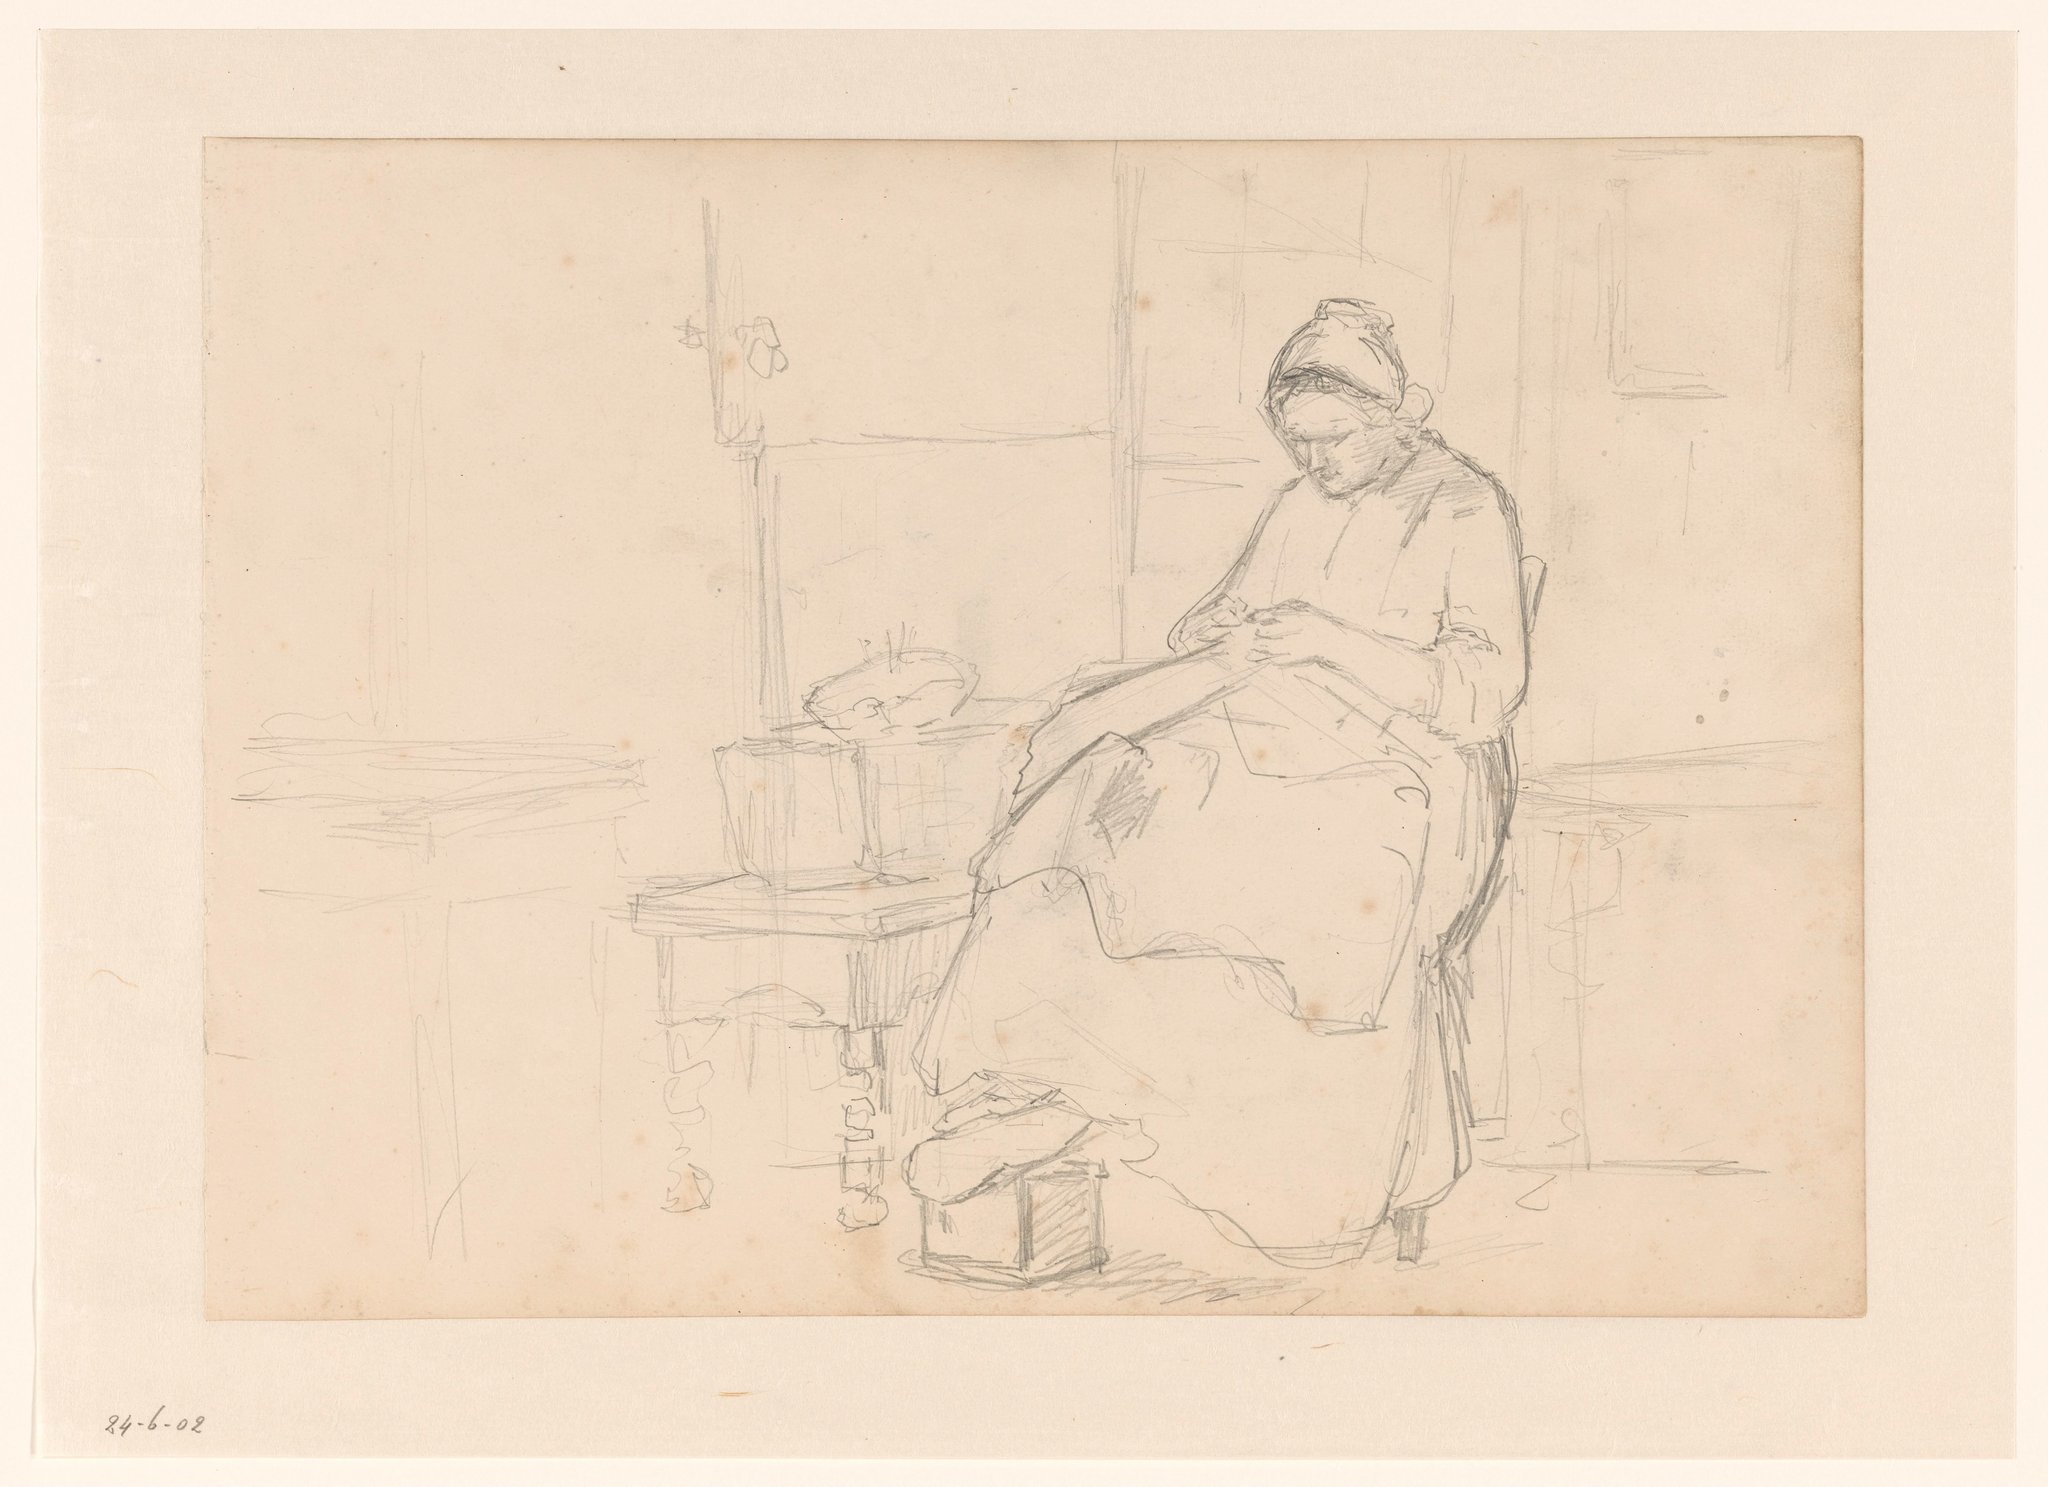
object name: watercolor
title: Zittende vrouw met naaiwerk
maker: hendrik valkenburg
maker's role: draughtsman, painter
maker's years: 1826-1896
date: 1836-1896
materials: paper, pencil, watercolor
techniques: brush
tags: interior of the house, home sewing; repair of clothes, household management; housewife at work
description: Zittende vrouw met naaiwerk. Verso: vrouw in deuropening met een mand om de kippen te voeren.